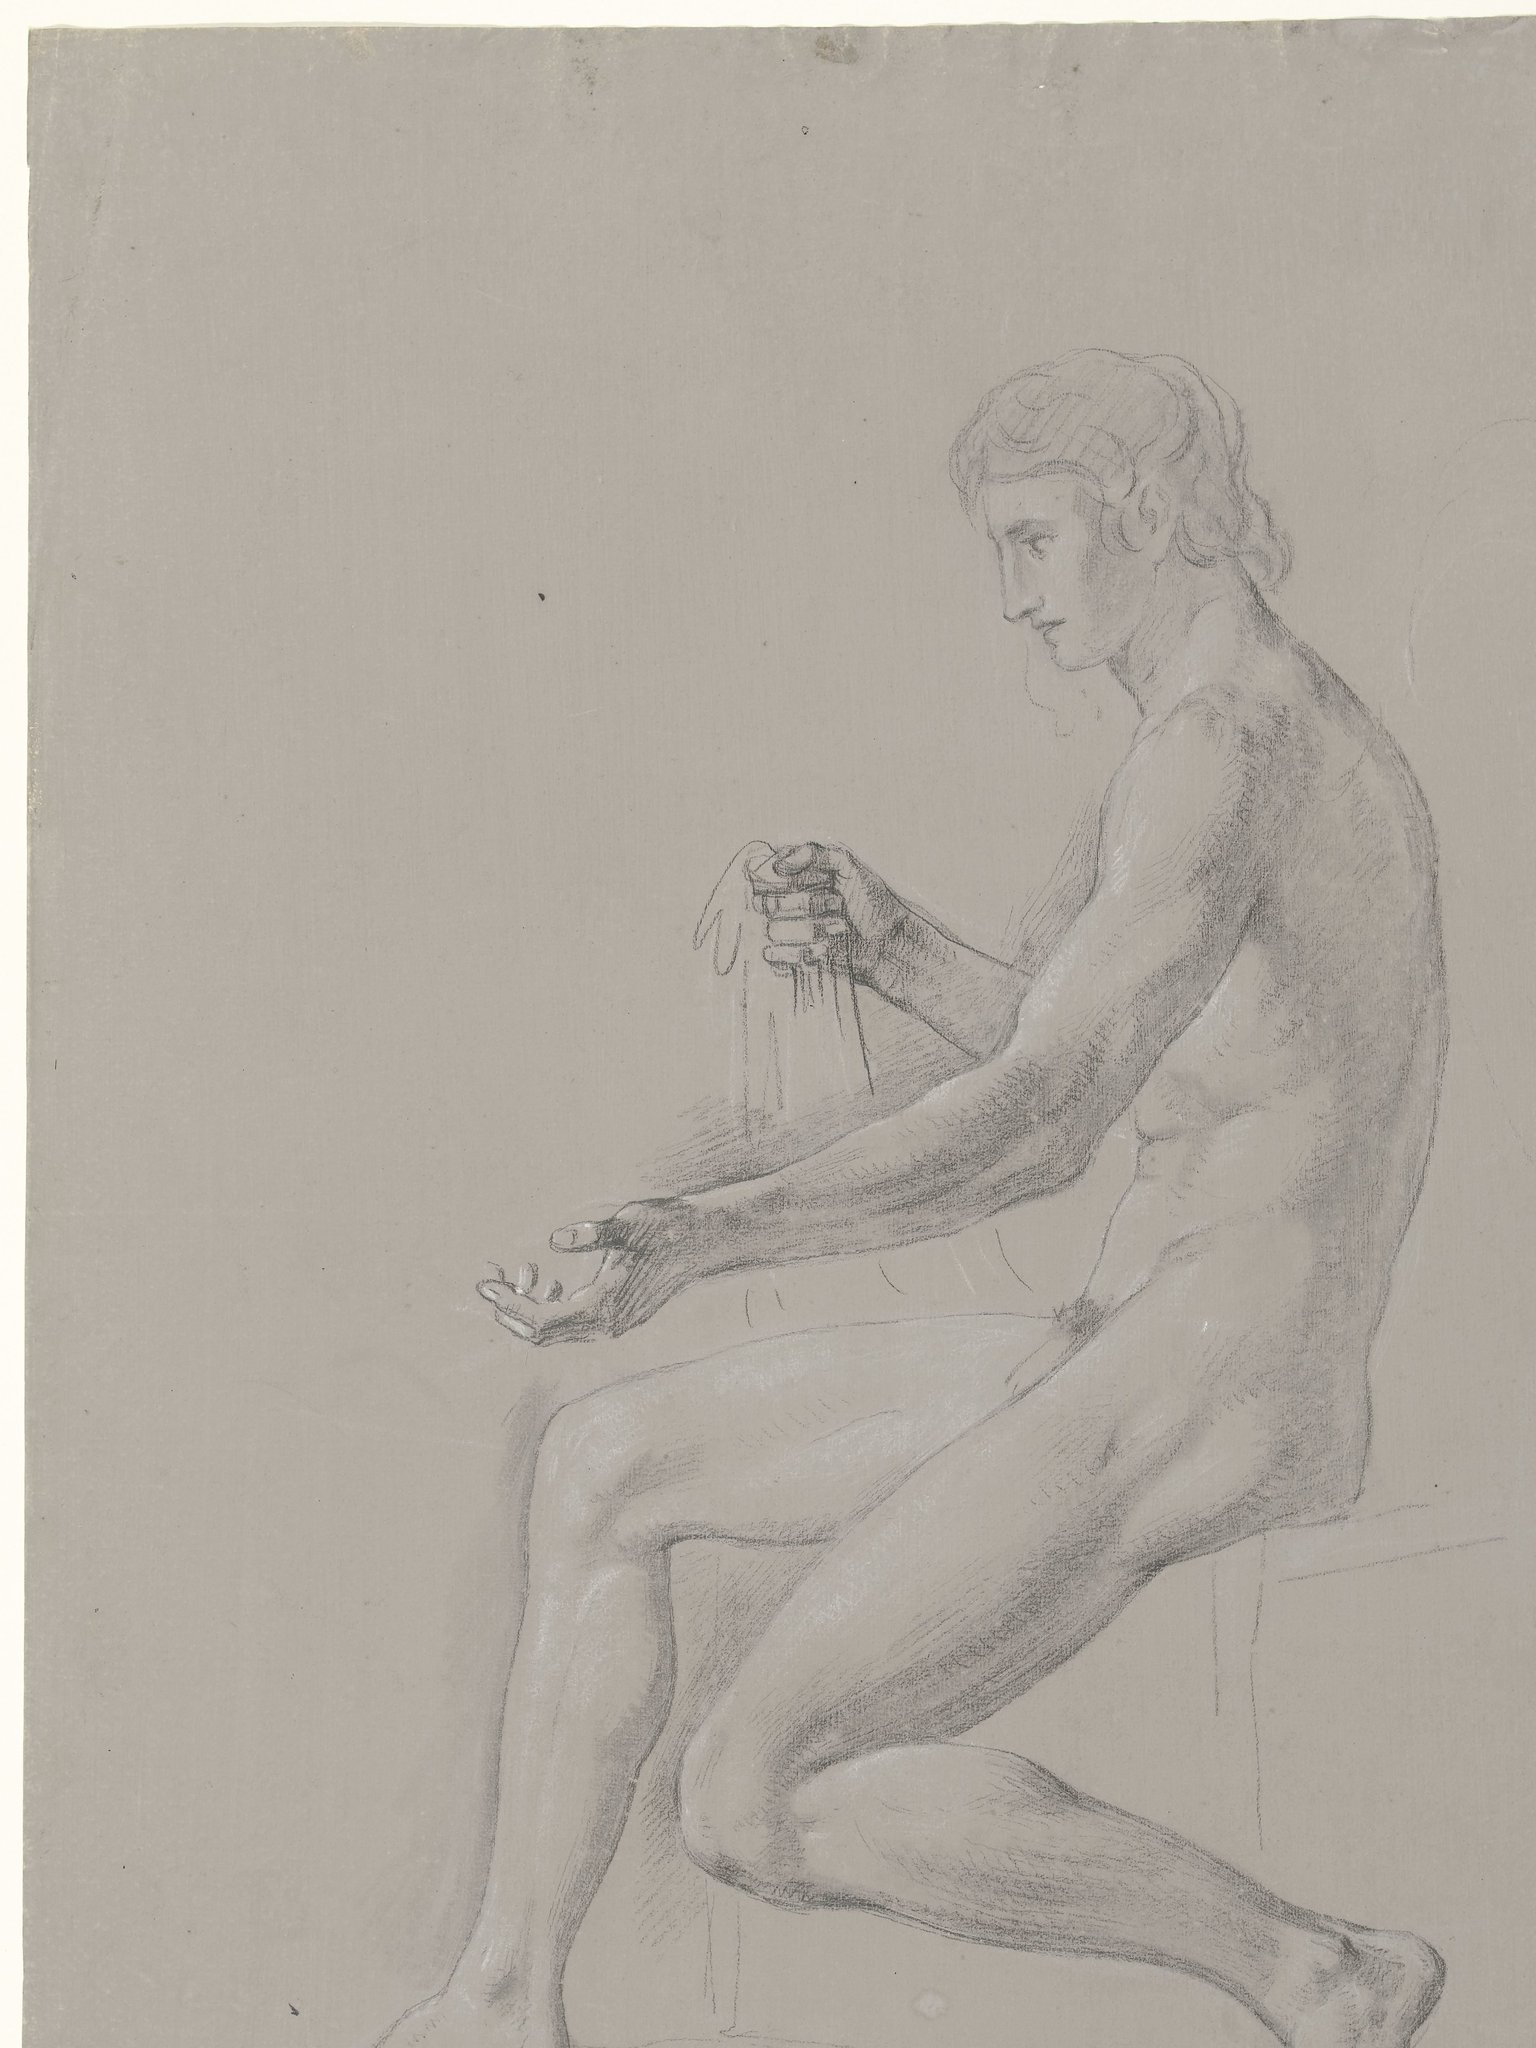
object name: drawing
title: Zittend mannelijk naakt, naar links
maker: jean grandjean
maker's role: draughtsman, print maker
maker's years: 1752-1781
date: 1765-1781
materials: chalk, paper